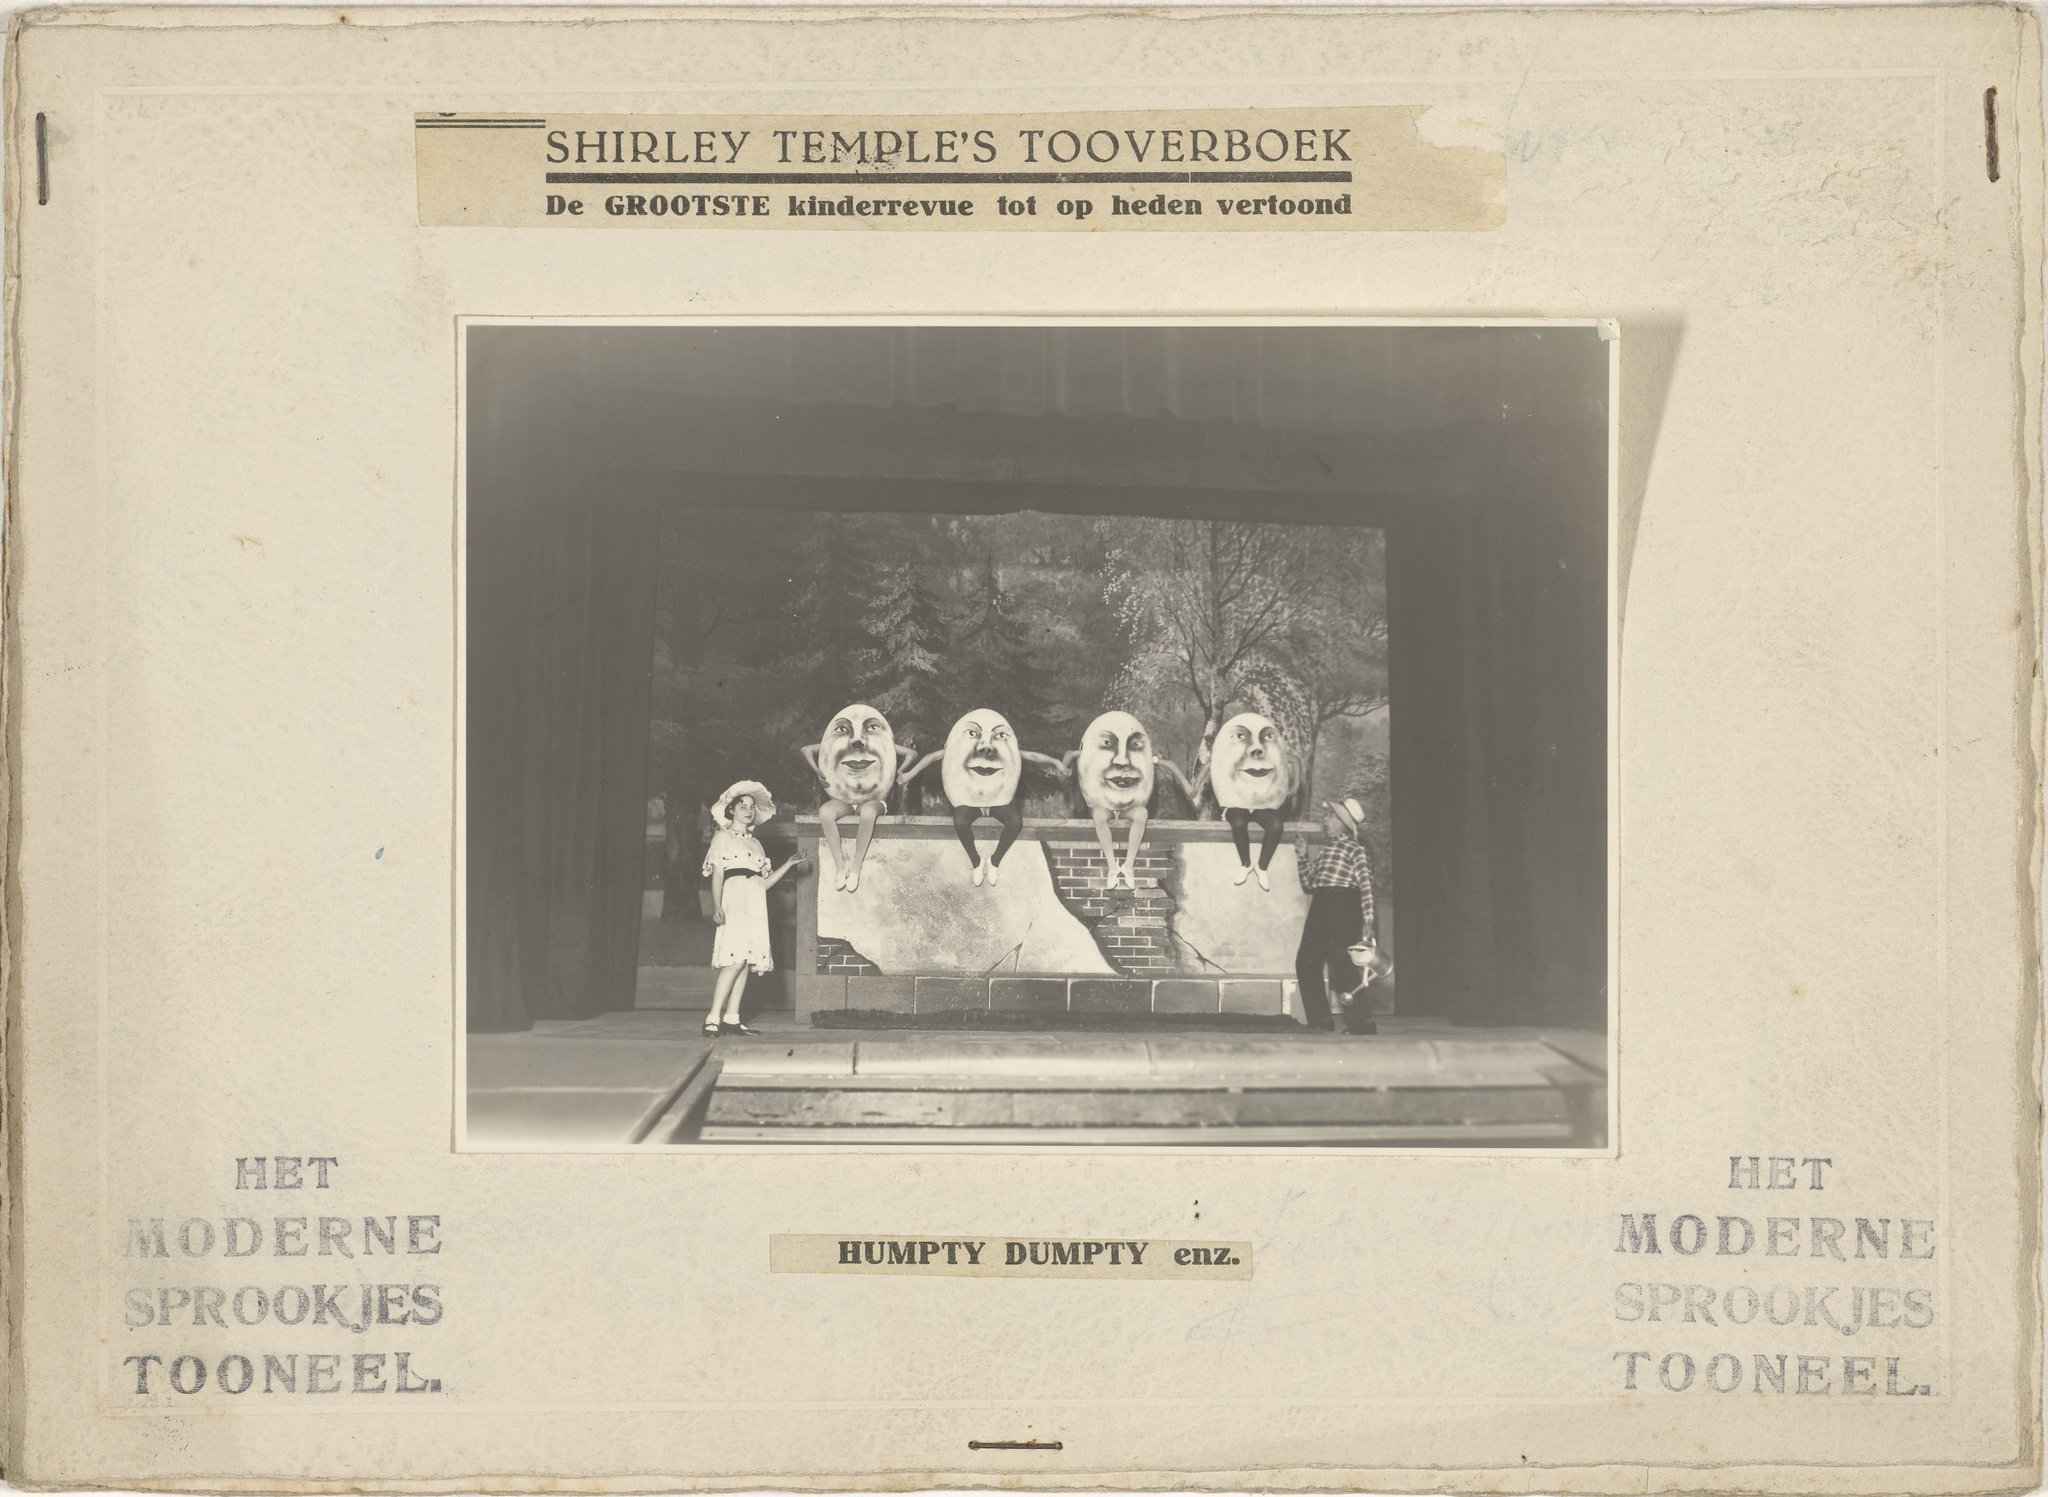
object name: photograph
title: Theaterfoto van acteurs als Humpty Dumpty's en Alice in Wonderland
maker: Anonymous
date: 1927-1935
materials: cardboard, photographic support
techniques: gelatin silver print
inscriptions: stamp: ‘Het moderne sprookjes toneel’